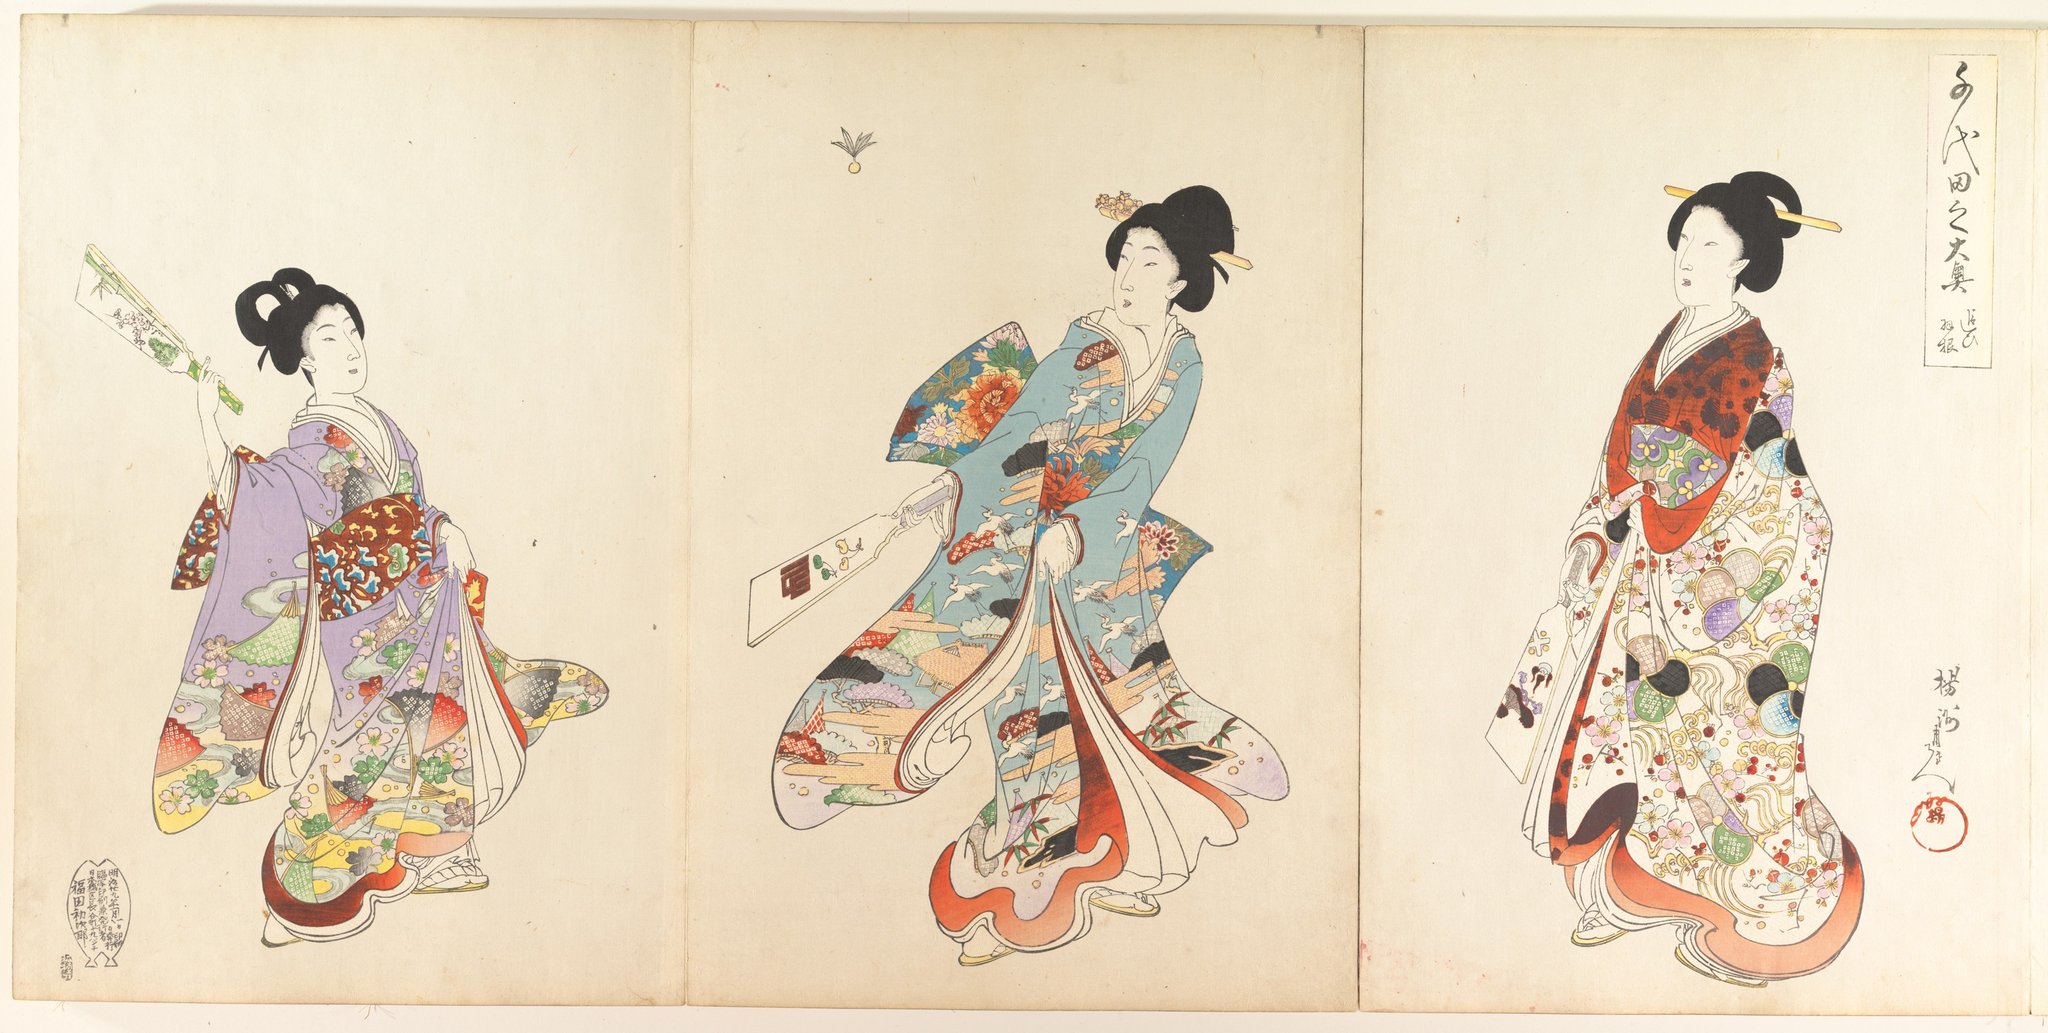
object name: print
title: Chiyoda Castle (Album of Women)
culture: japanese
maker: yōshū (hashimoto) chikanobu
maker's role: artist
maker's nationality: japanese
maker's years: 1838-1912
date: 1895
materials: ink, paper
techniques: woodblock print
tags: women